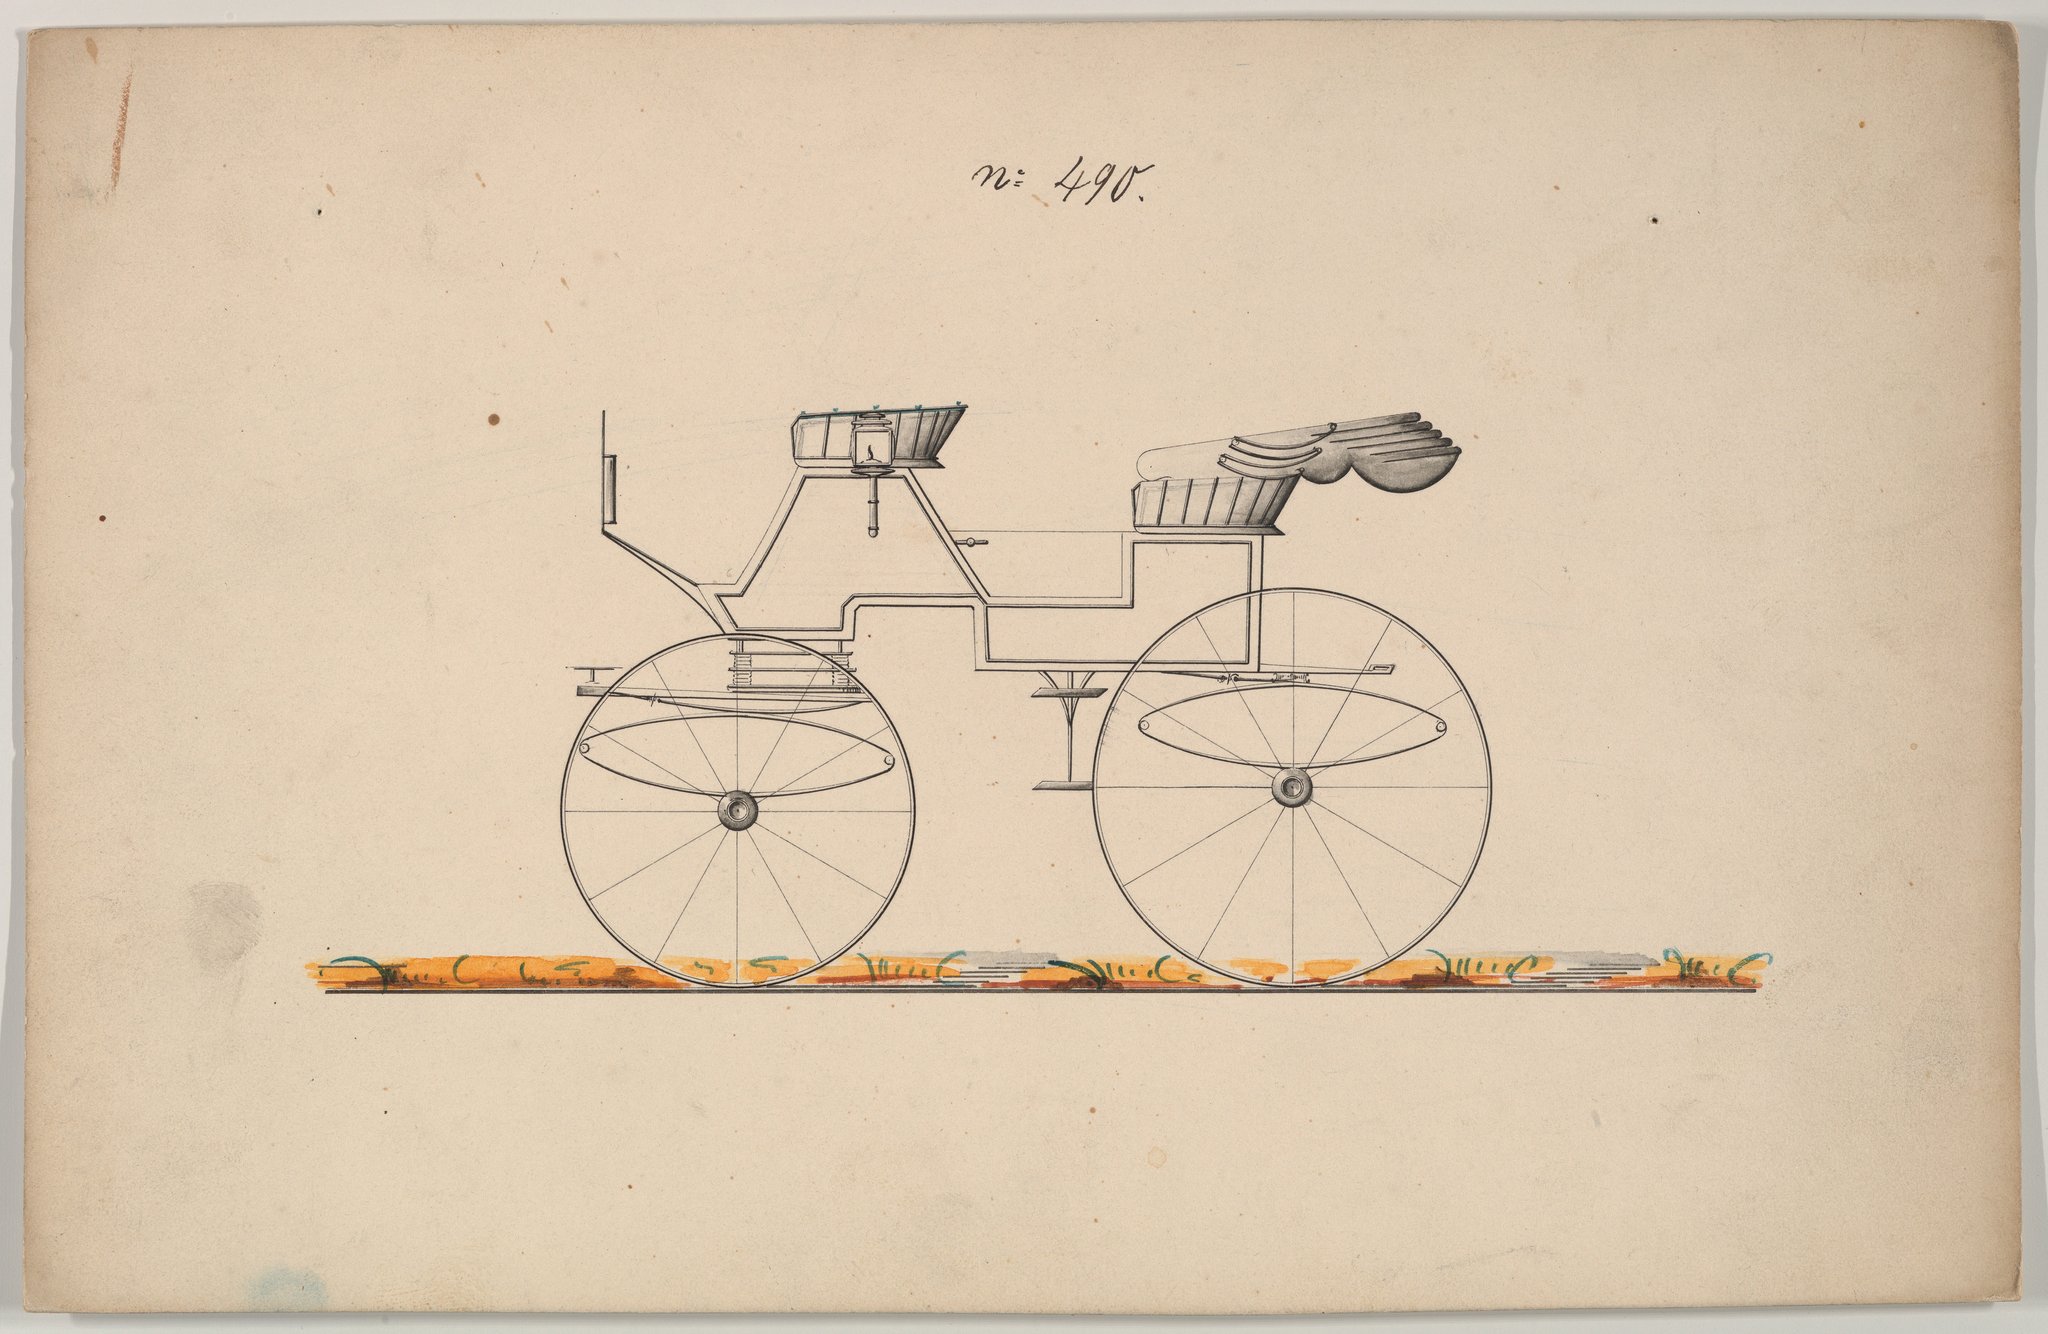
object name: drawing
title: Design for Phaeton, no. 490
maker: brewster & co.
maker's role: manufacturer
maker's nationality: american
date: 1850-1874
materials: gouache, ink, watercolor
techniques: pen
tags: carriages